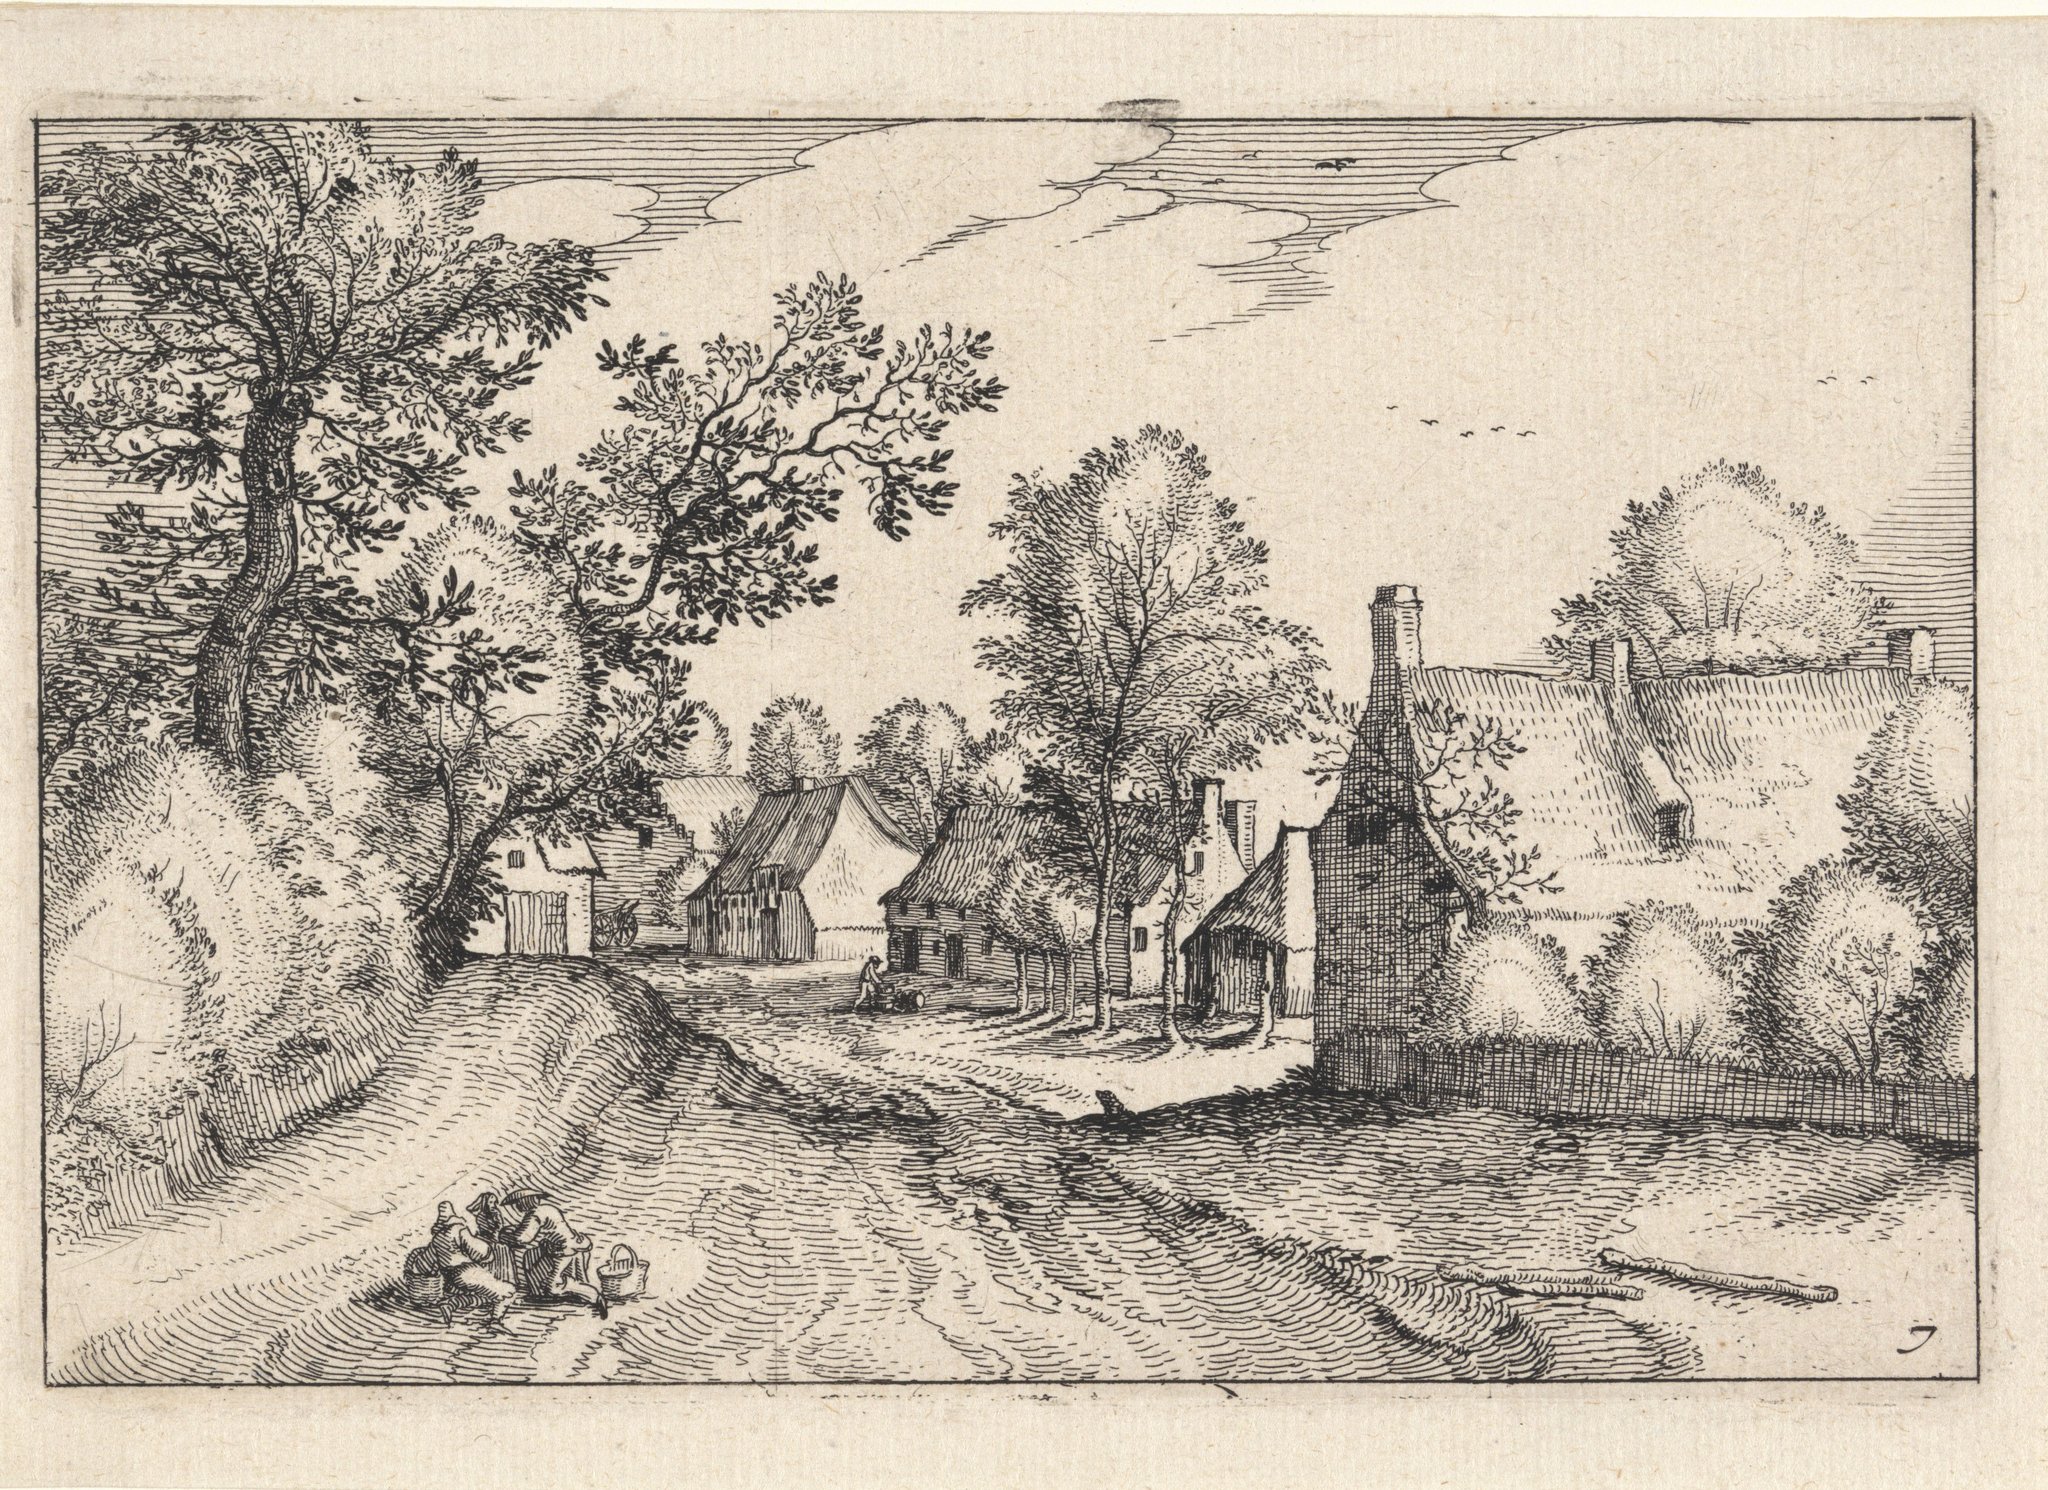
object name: print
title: Enkele figuren op een weg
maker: claes jansz. visscher (ii)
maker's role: draughtsman, print maker, publisher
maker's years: 1586-1652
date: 1612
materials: paper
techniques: etching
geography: amsterdam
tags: village street, farm or solitary house in landscape, eating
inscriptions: collector's mark: Lugt 240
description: Gezicht op een rij huizen aan een onverharde weg. Op de voorgrond gebruiken drie figuren met manden de maaltijd.